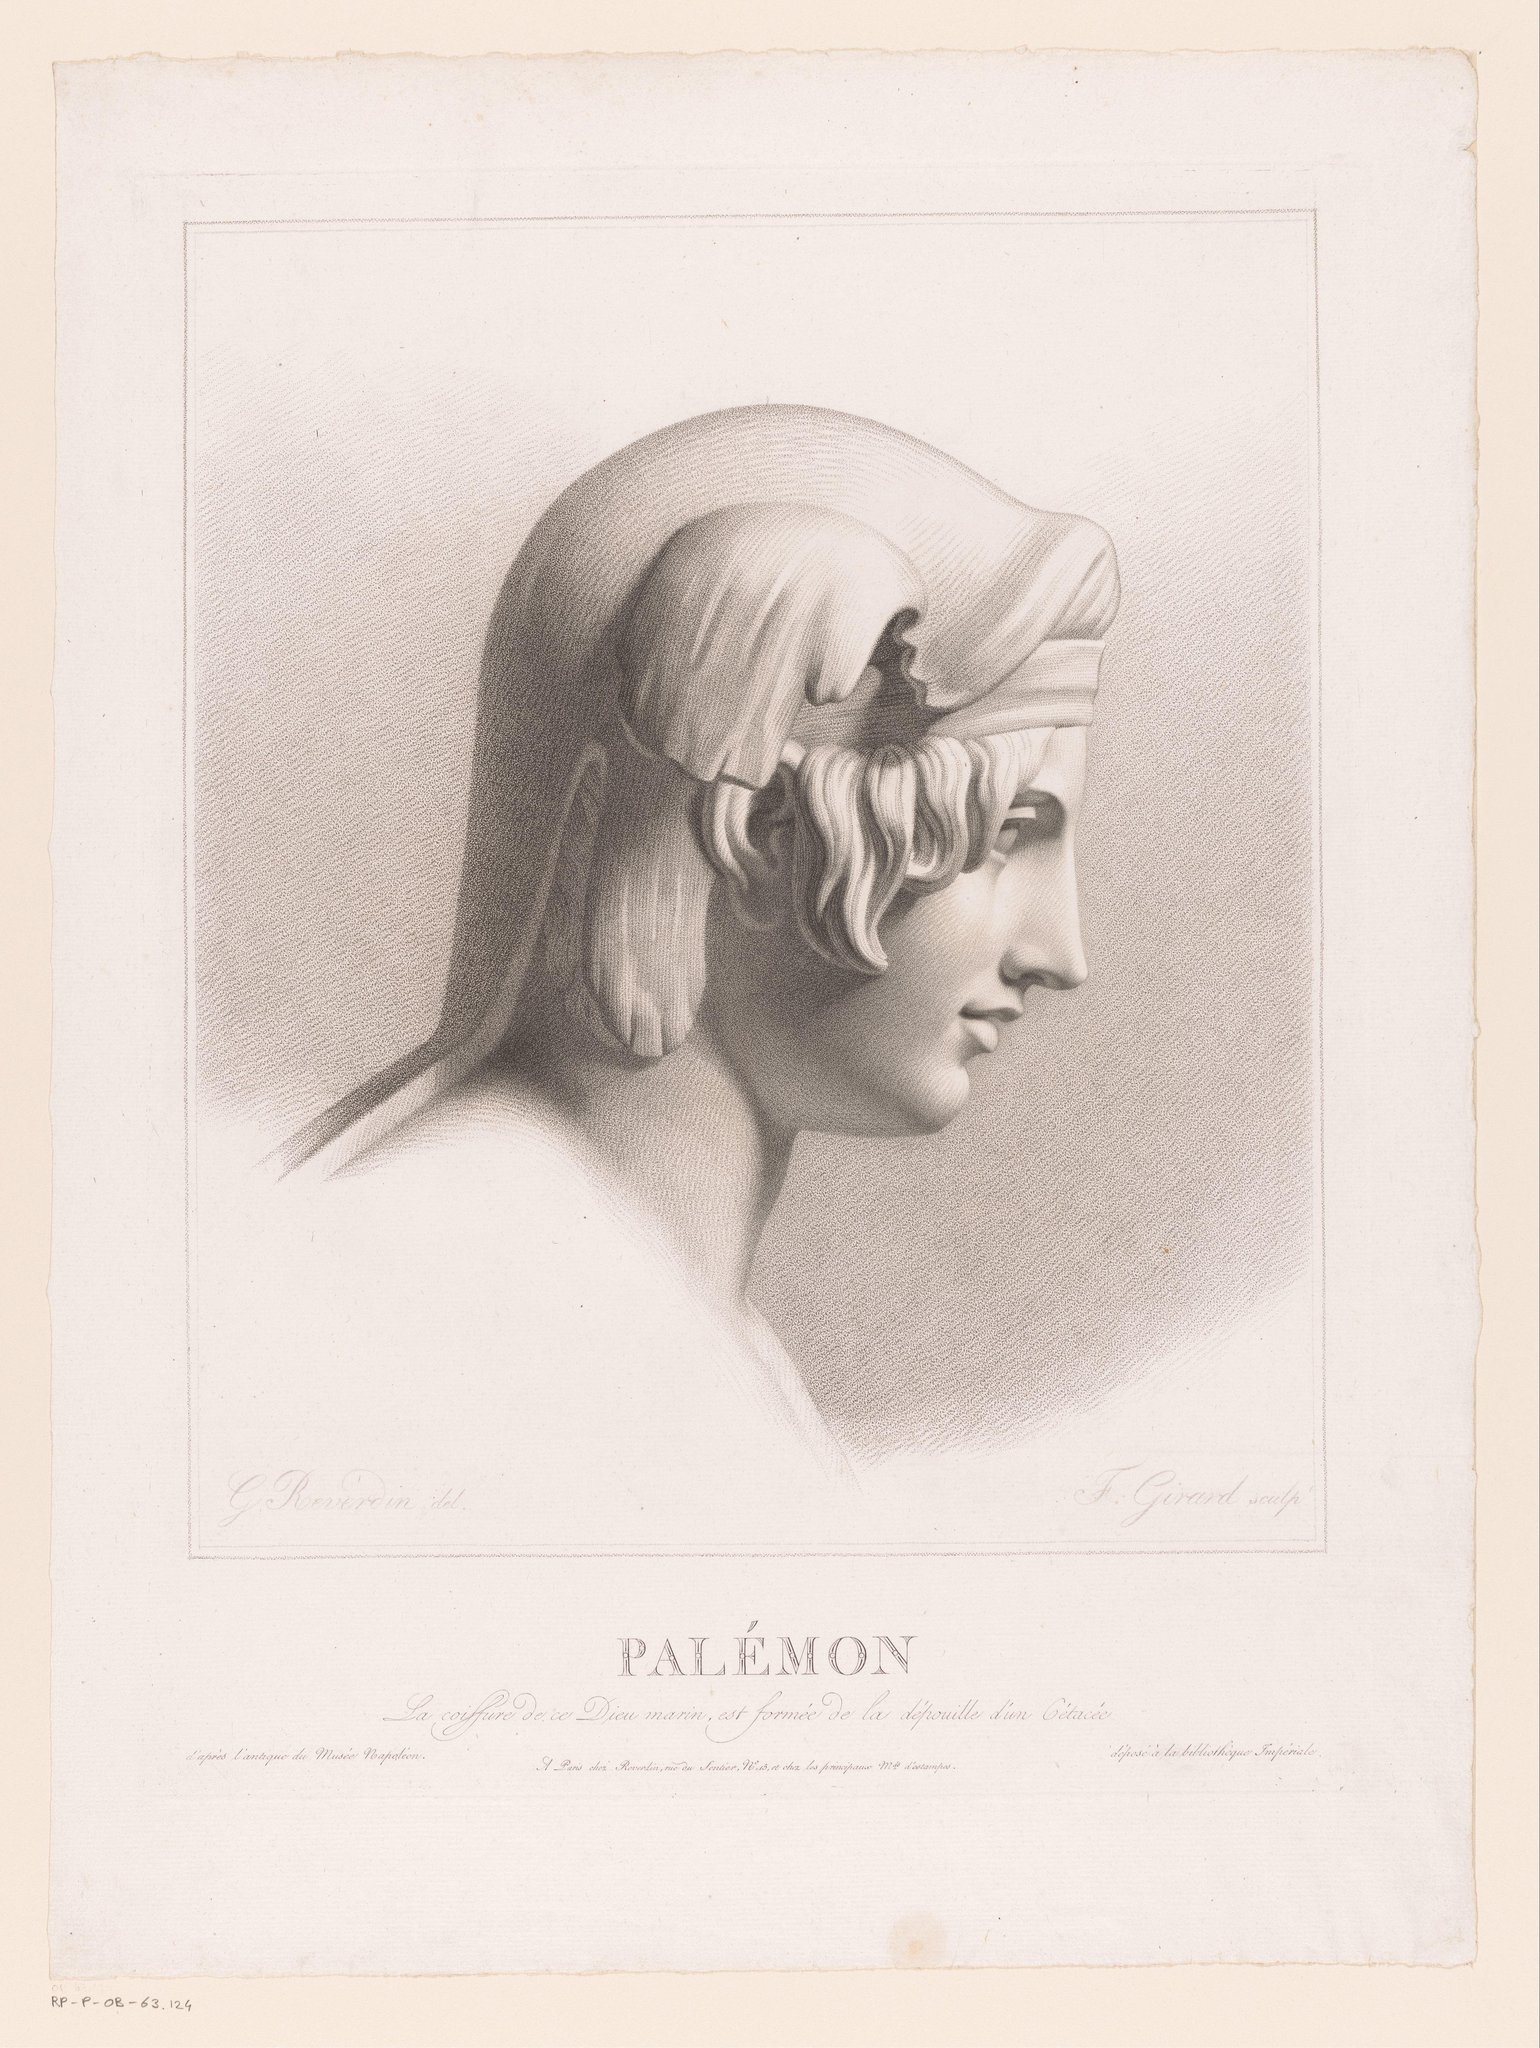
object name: print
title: Hoofd van Palaemon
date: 1797-1828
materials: paper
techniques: engraving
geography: paris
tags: piece of sculpture, reproduction of a piece of sculpture, (story of) palaemon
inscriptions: : ‘déposé à la bibliothèque Impériale.’, collector's mark: Lugt 2228